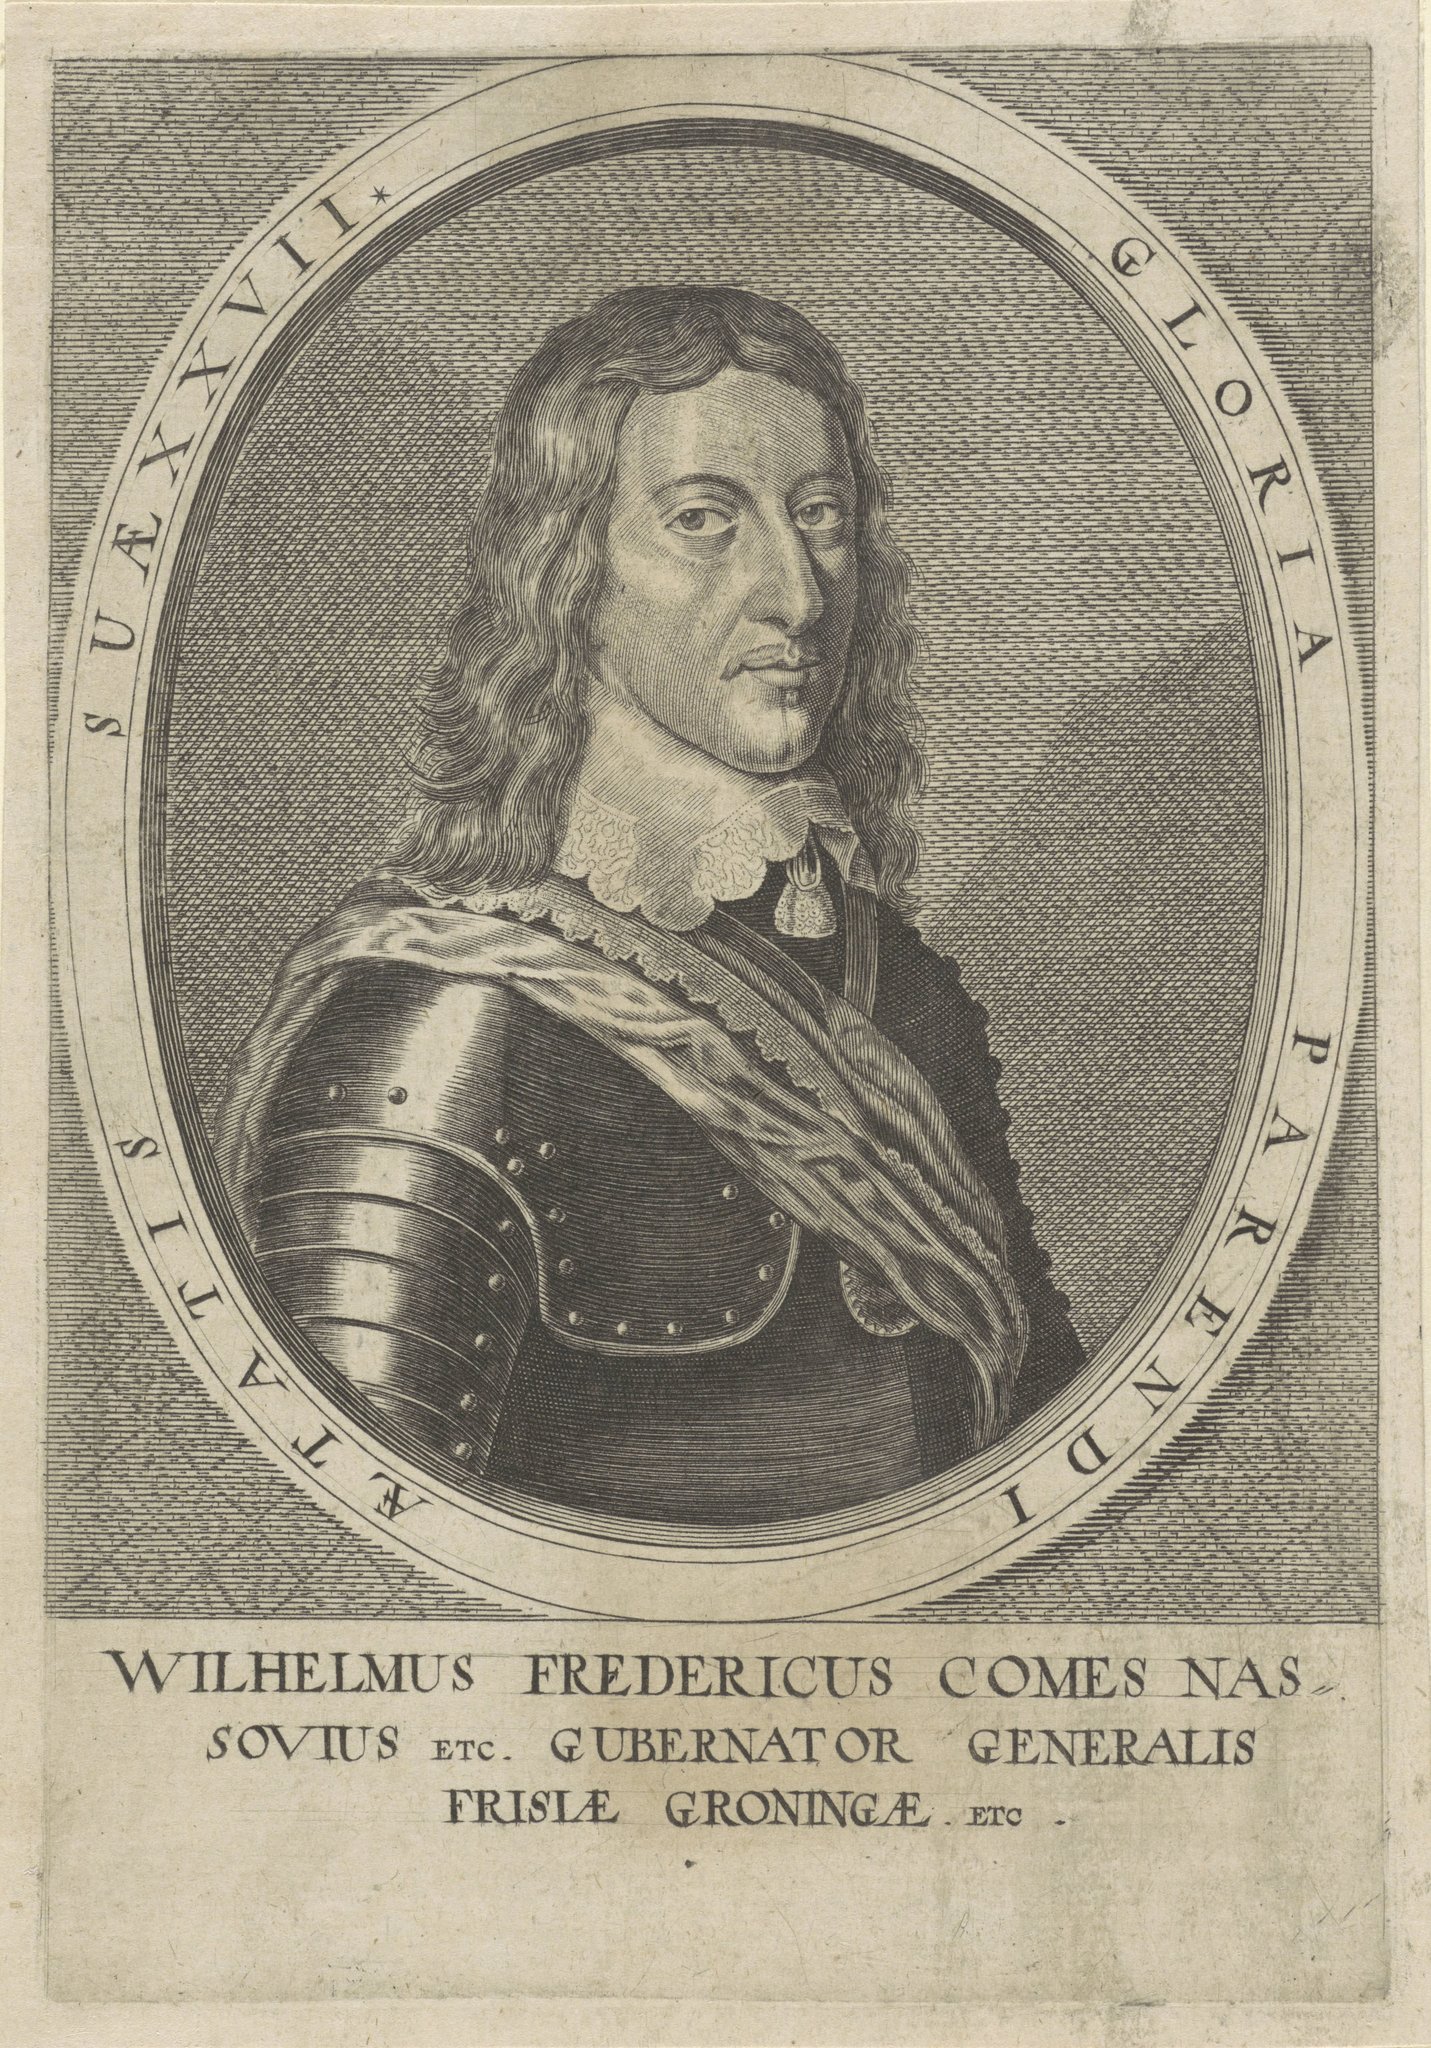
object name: print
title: Portret van Willem Frederik, graaf van Nassau-Dietz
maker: crispijn van den queborn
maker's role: print maker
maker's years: 1595-1652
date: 1640-1652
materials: paper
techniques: engraving, etching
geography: the hague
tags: arnhem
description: De hier vermelde titel verwijst naar de hoogst verkregen titel van de geportretteerde, niet per se naar de titel die de geportretteerde op deze voorstelling draagt.